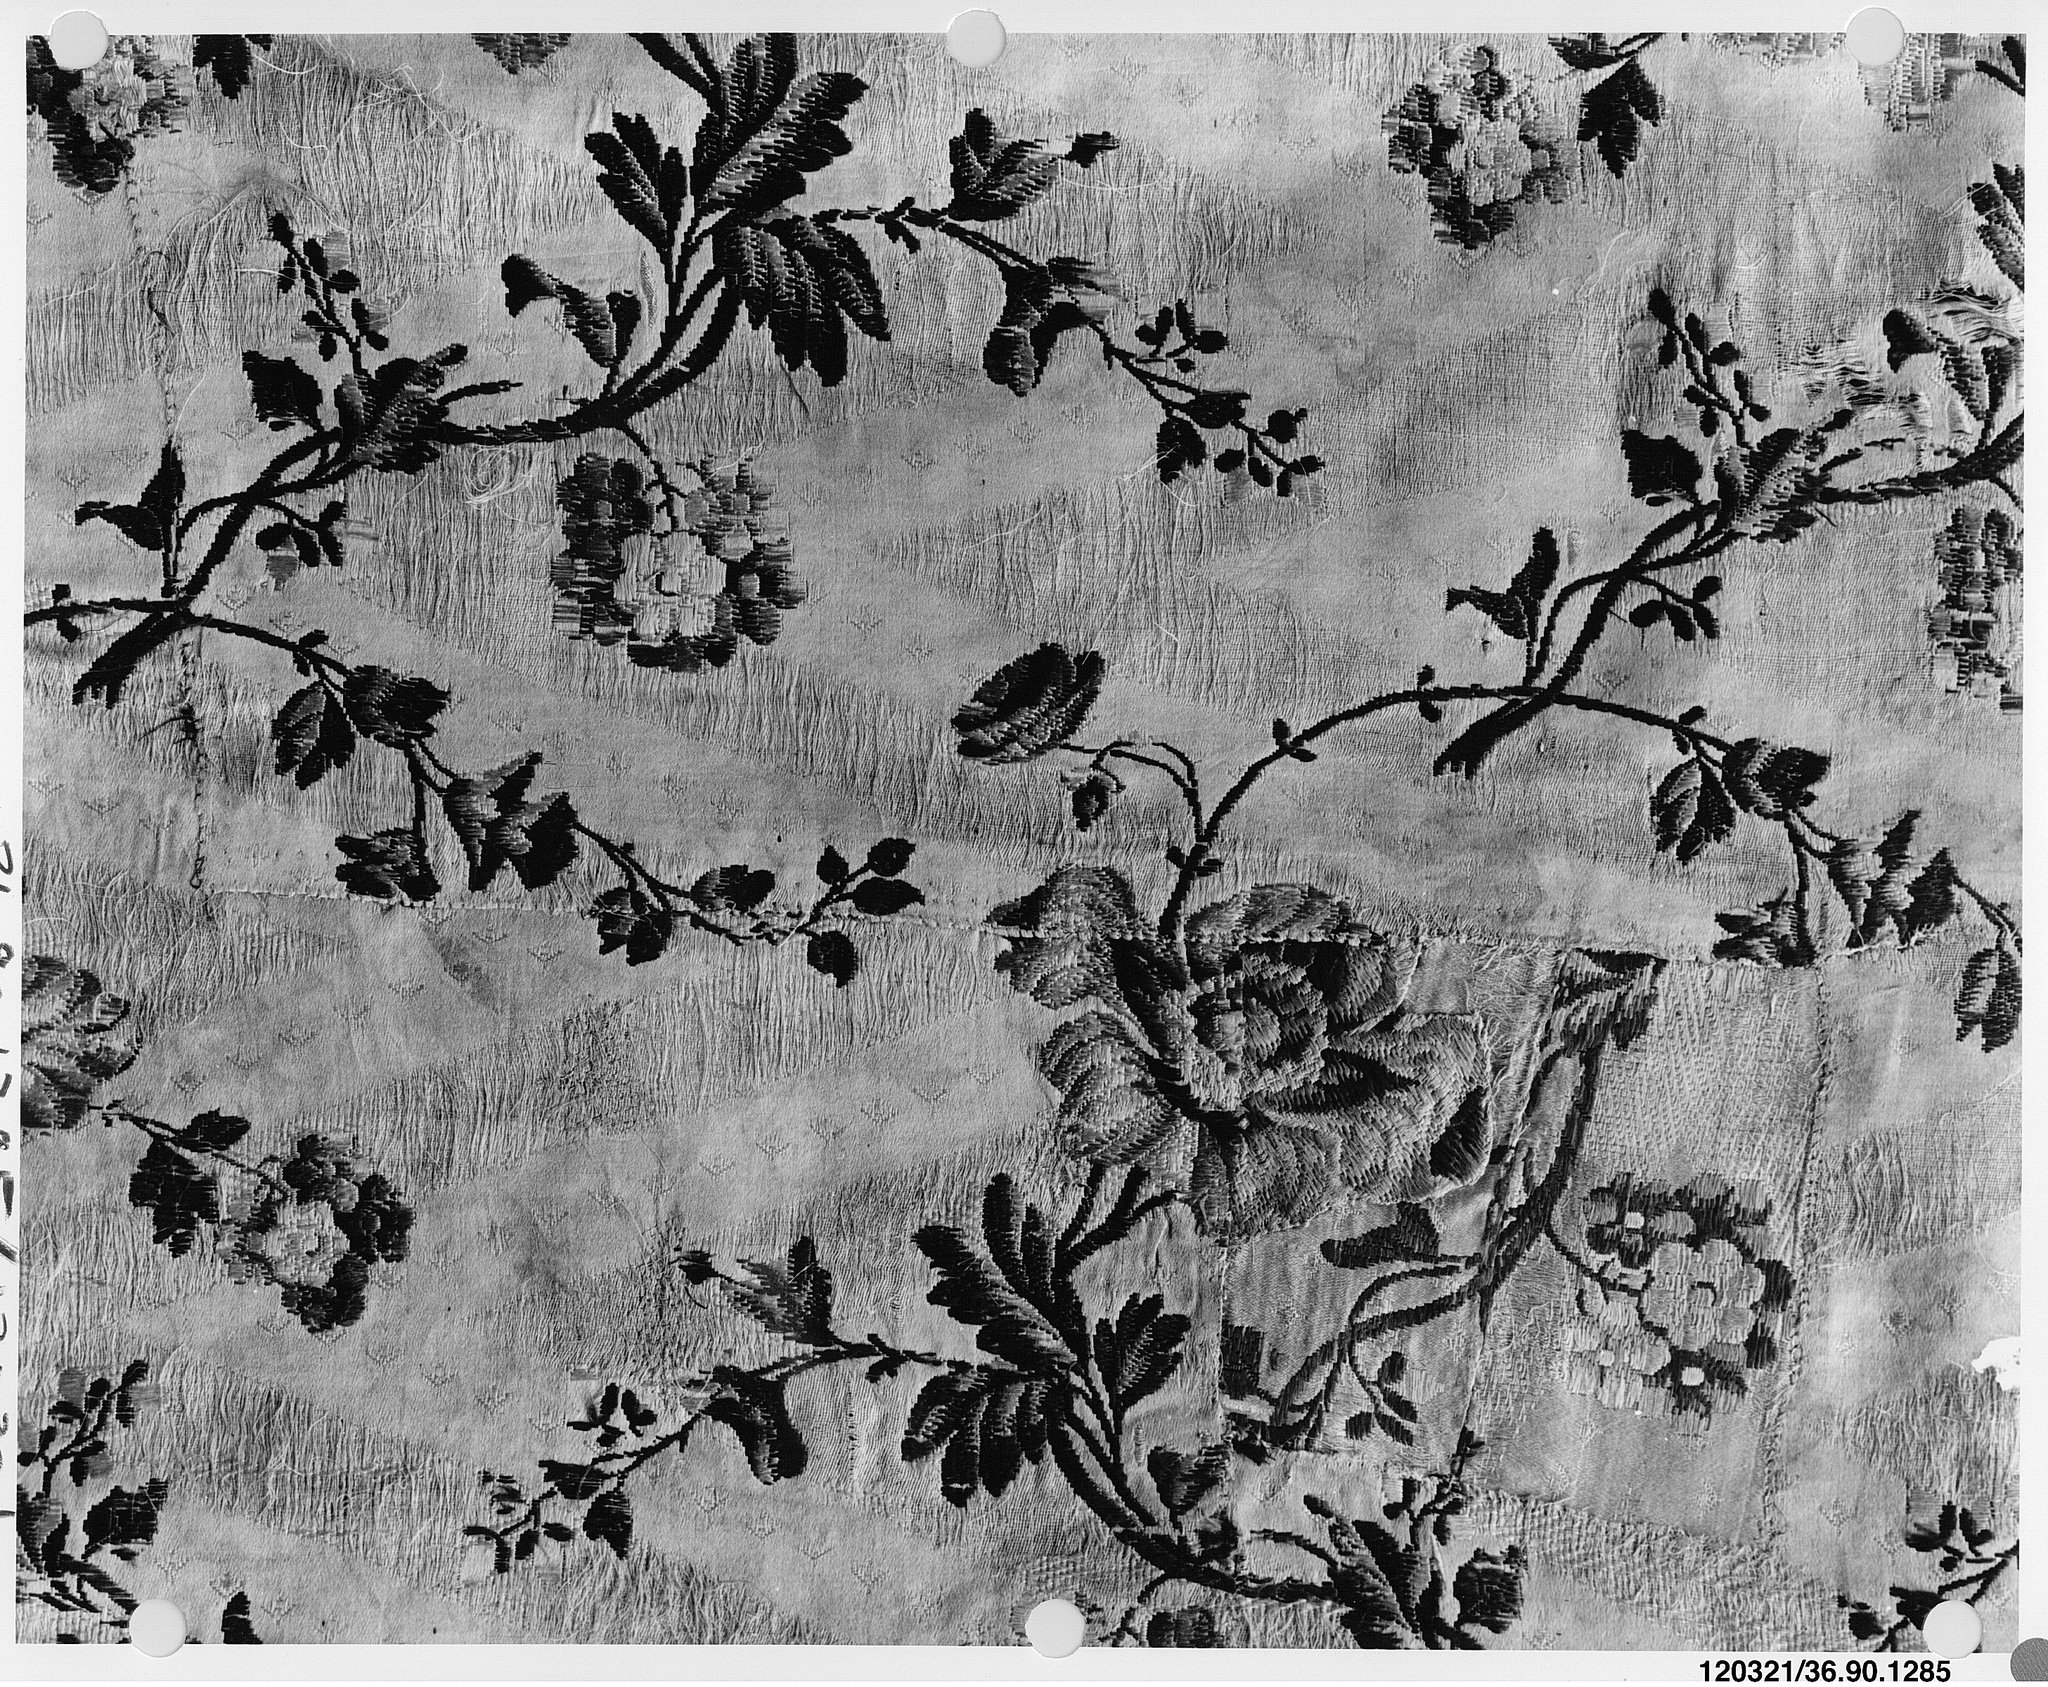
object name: piece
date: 1745-1750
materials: silk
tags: flowers,leaves